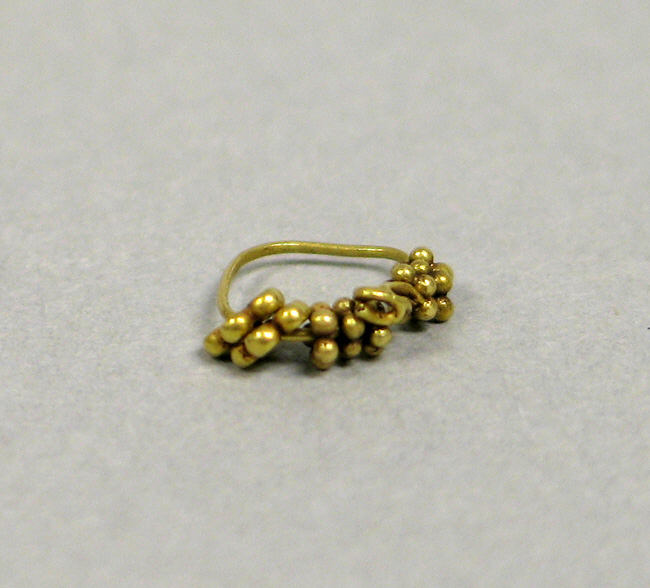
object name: ear clip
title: Pair of Ear Clips with Granulate Clusters on Hoops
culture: indonesian, javanese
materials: gold